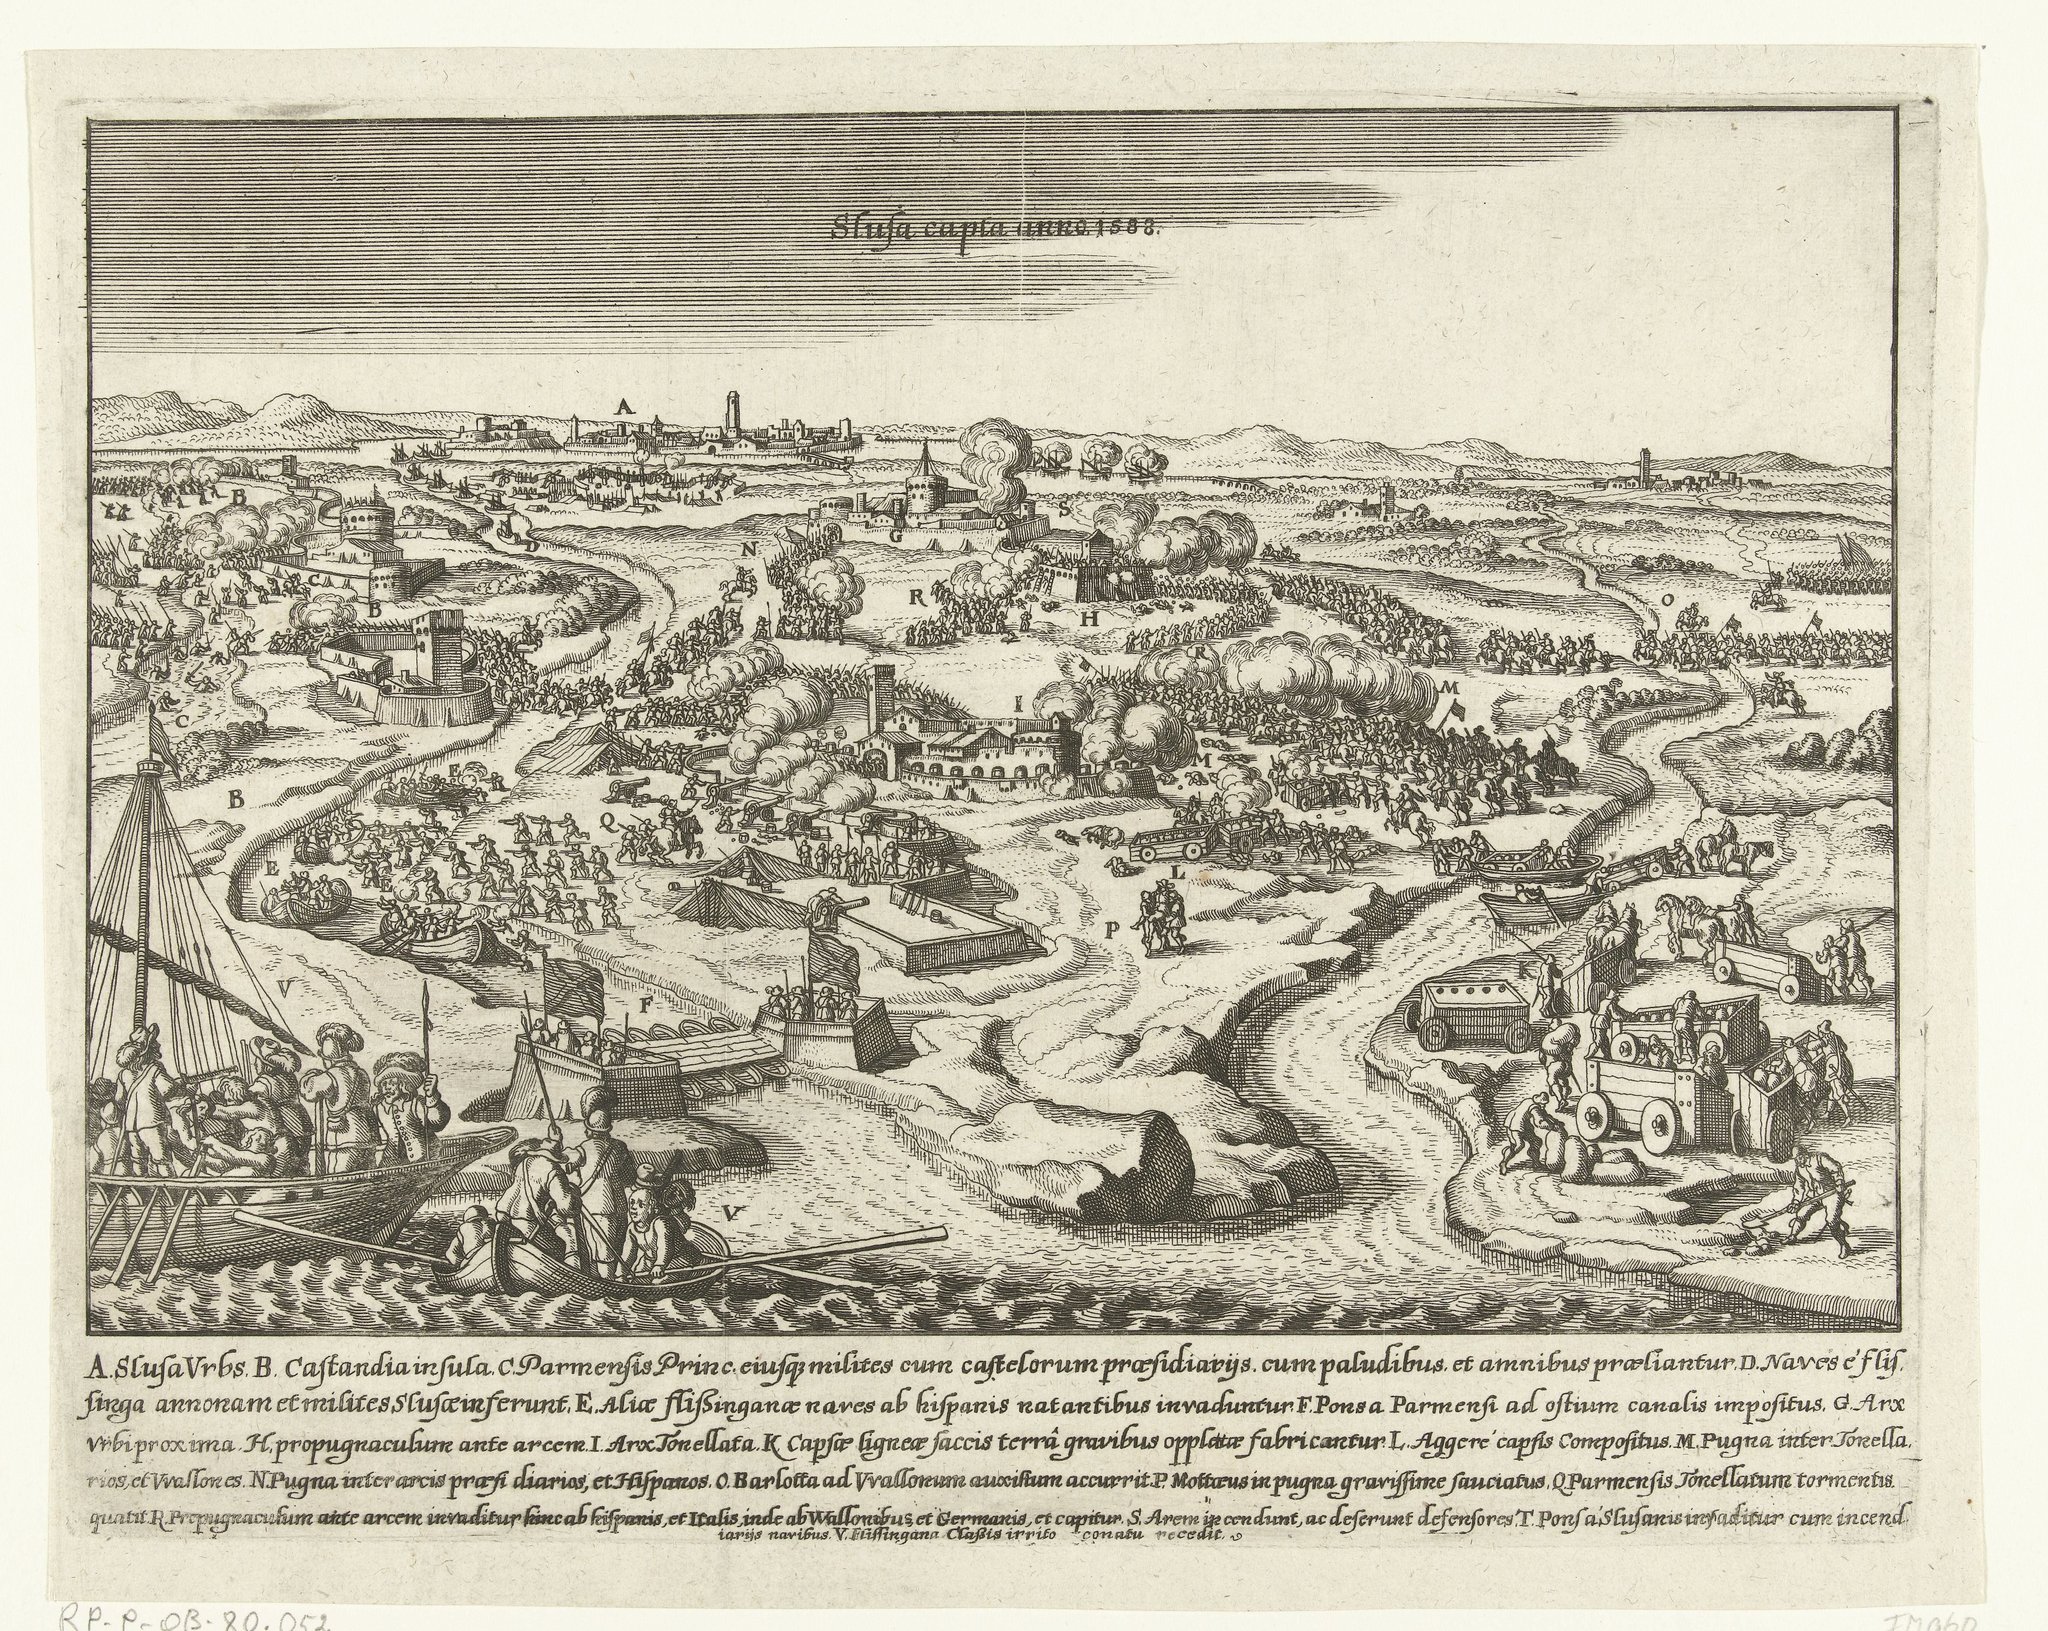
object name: print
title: Beleg van Sluis door Parma, 1587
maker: Anonymous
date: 1649-1651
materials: paper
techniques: etching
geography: rome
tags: siege, position war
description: Beleg en verovering van Sluis door het leger van Parma, 5 augustus 1587. Overzicht van de gevechten rond het beleg, de pogingen tot ontzet en de verovering van Sluis. Links op de voorgrond schepen van de vloot van Leicester bij het water afgesloten door schepen van Parma. In de verte de stad. Bovenaan de titel, in het onderschrift de legenda A-V in het Latijn.